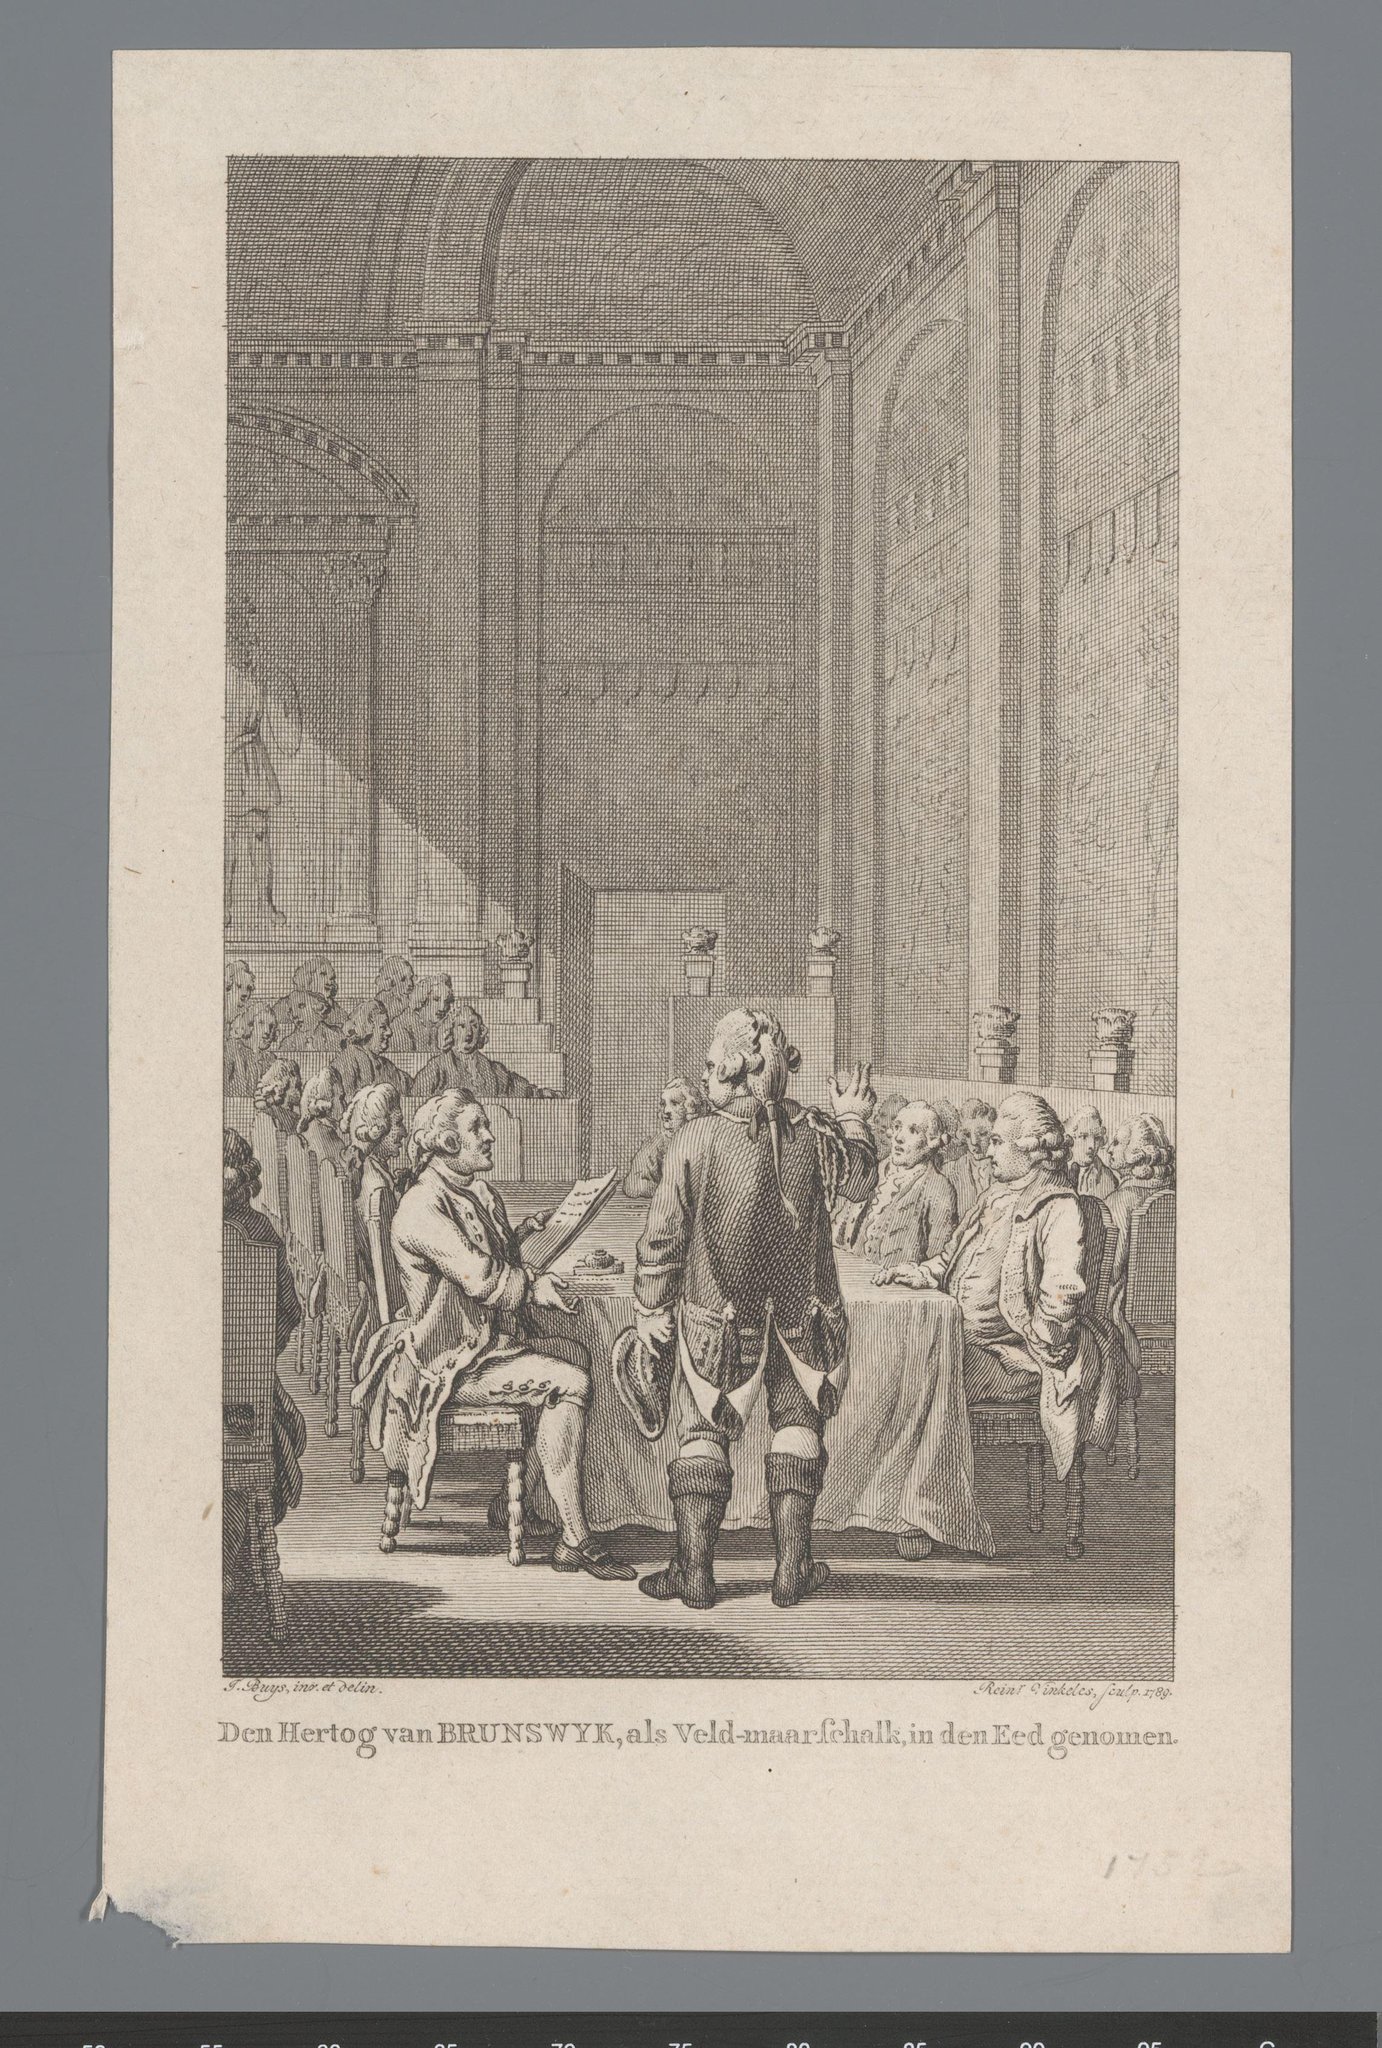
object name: print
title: Lodewijk Ernst, hertog van Brunswijk legt de eed af als veldmaarschalk, 1759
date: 1789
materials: paper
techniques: engraving, etching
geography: northern netherlands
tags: the hague, william v (prince of orange), ludwig ernst von braunschweig-wolfenbüttel, new ruler taking the oath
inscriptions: date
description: Gebruikt in: Loosjes, P.A. Vaderlandsche historie, vervattende de geschiedenissen, der Vereenigde Nederlanden (...). Drie-en-twintigste deel. Beginnende met den jaare 1759 en eindigende met den jaare 1765, bevattende het tydperk der minderjaarigheid des erfstadhouders Willem den V. Ten onmiddelyken vervolge van Wagenaar's Vaderlandsche historie. Amsterdam: J. Allart, 1797.